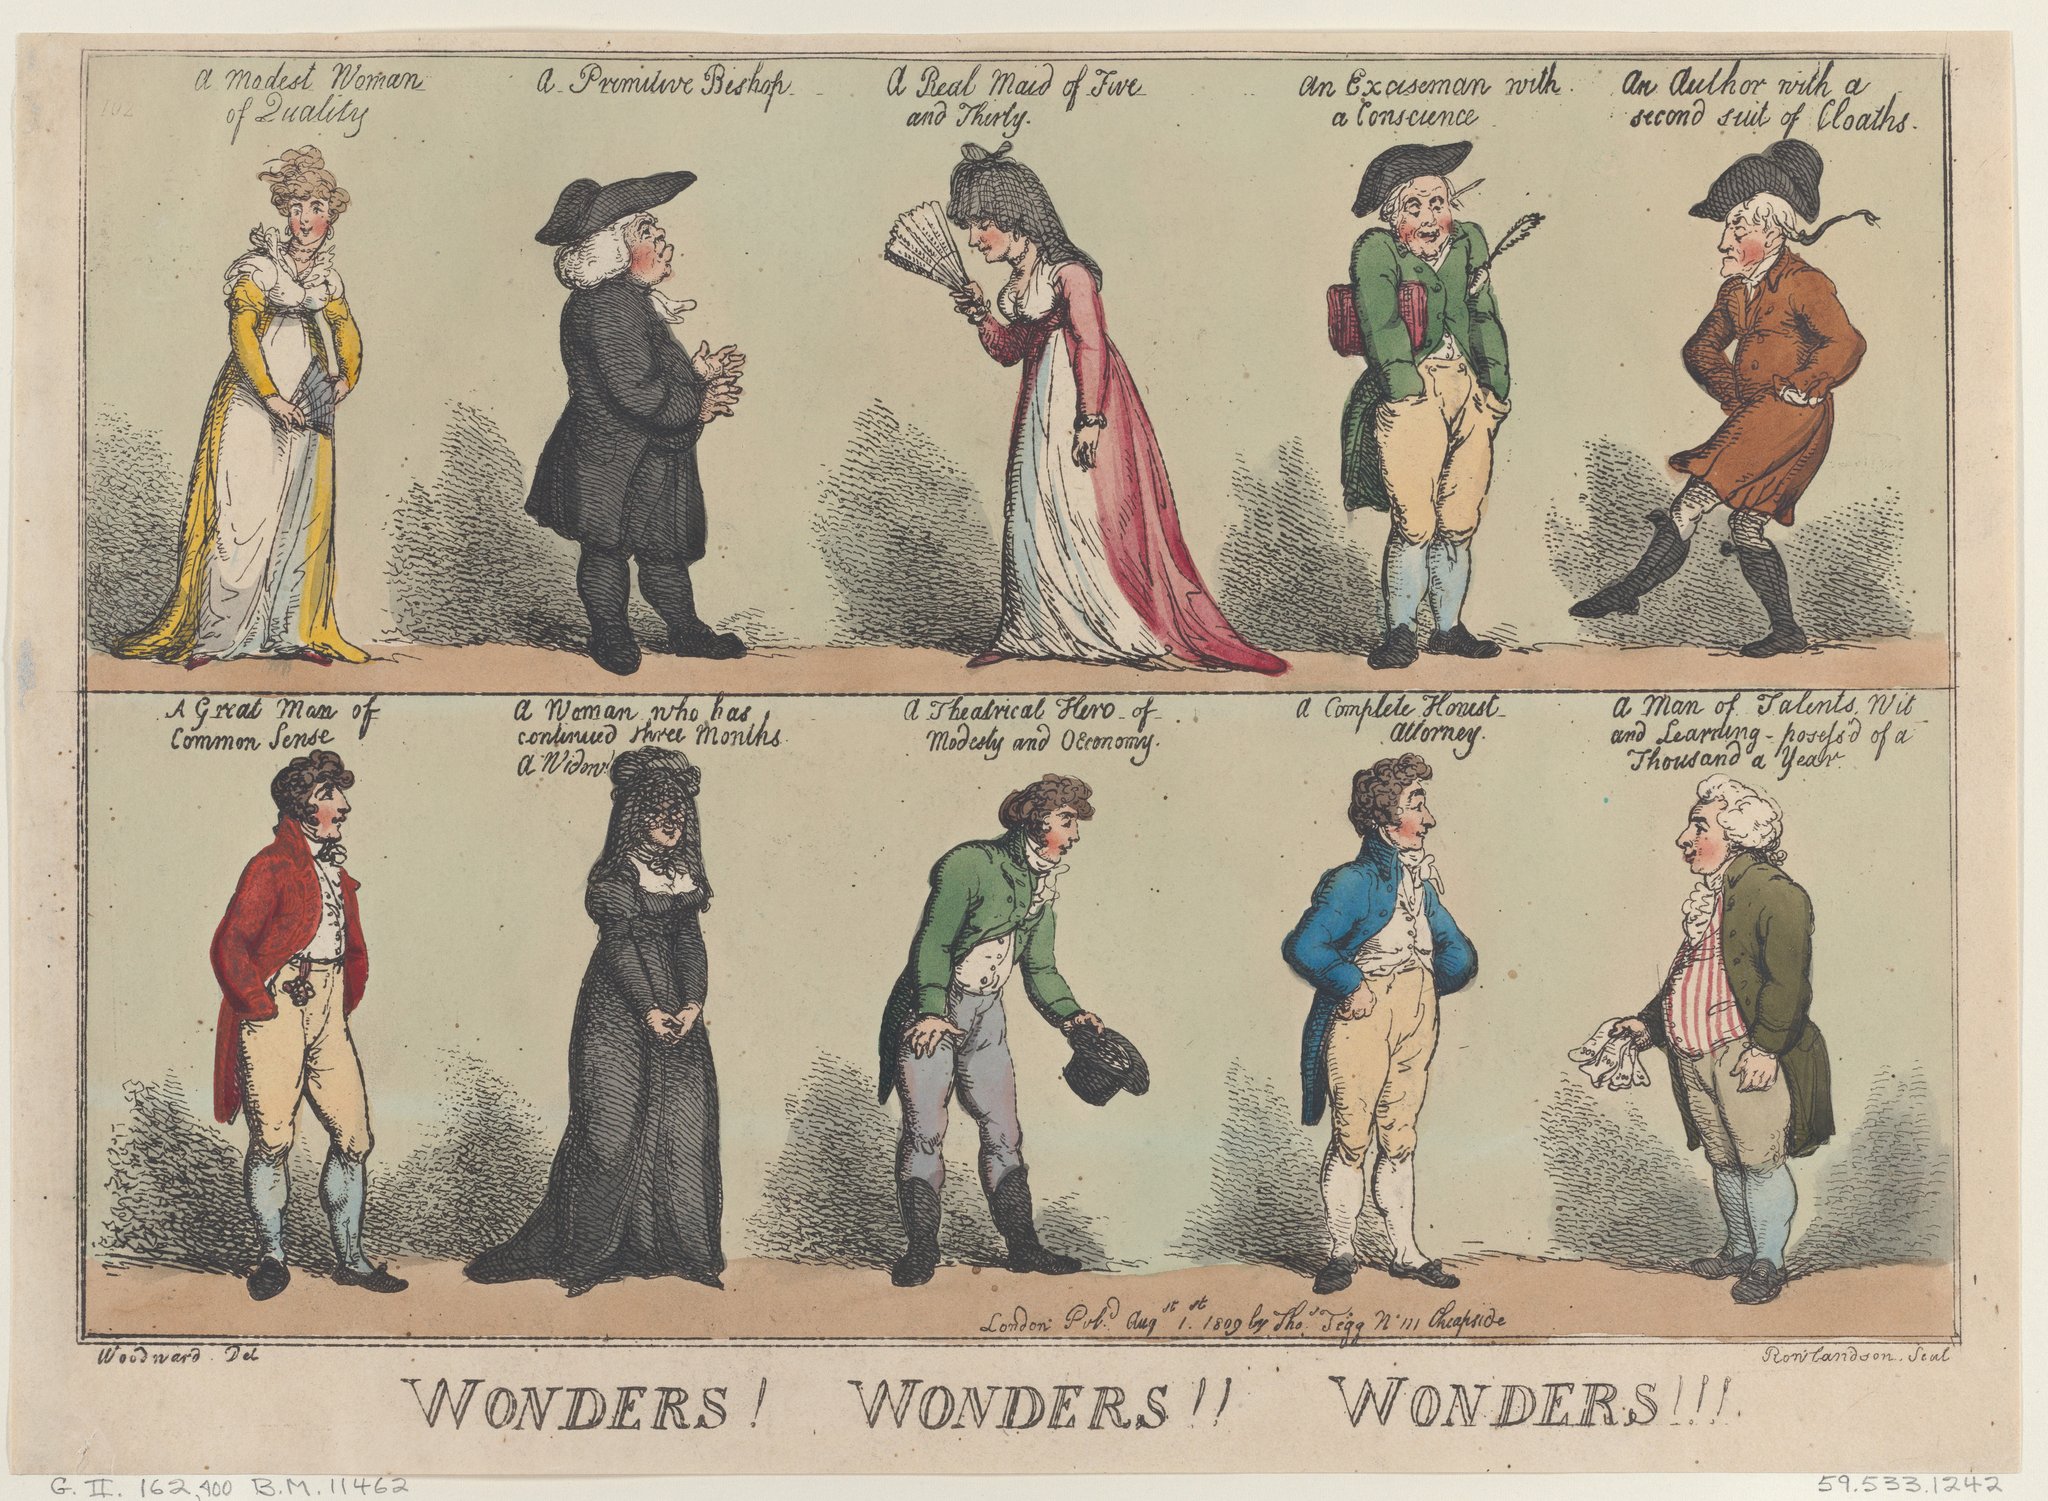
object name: print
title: Wonders! Wonders!! Wonders!!!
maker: thomas rowlandson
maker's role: artist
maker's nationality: british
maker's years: 1757-1827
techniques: etching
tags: satire,men,women